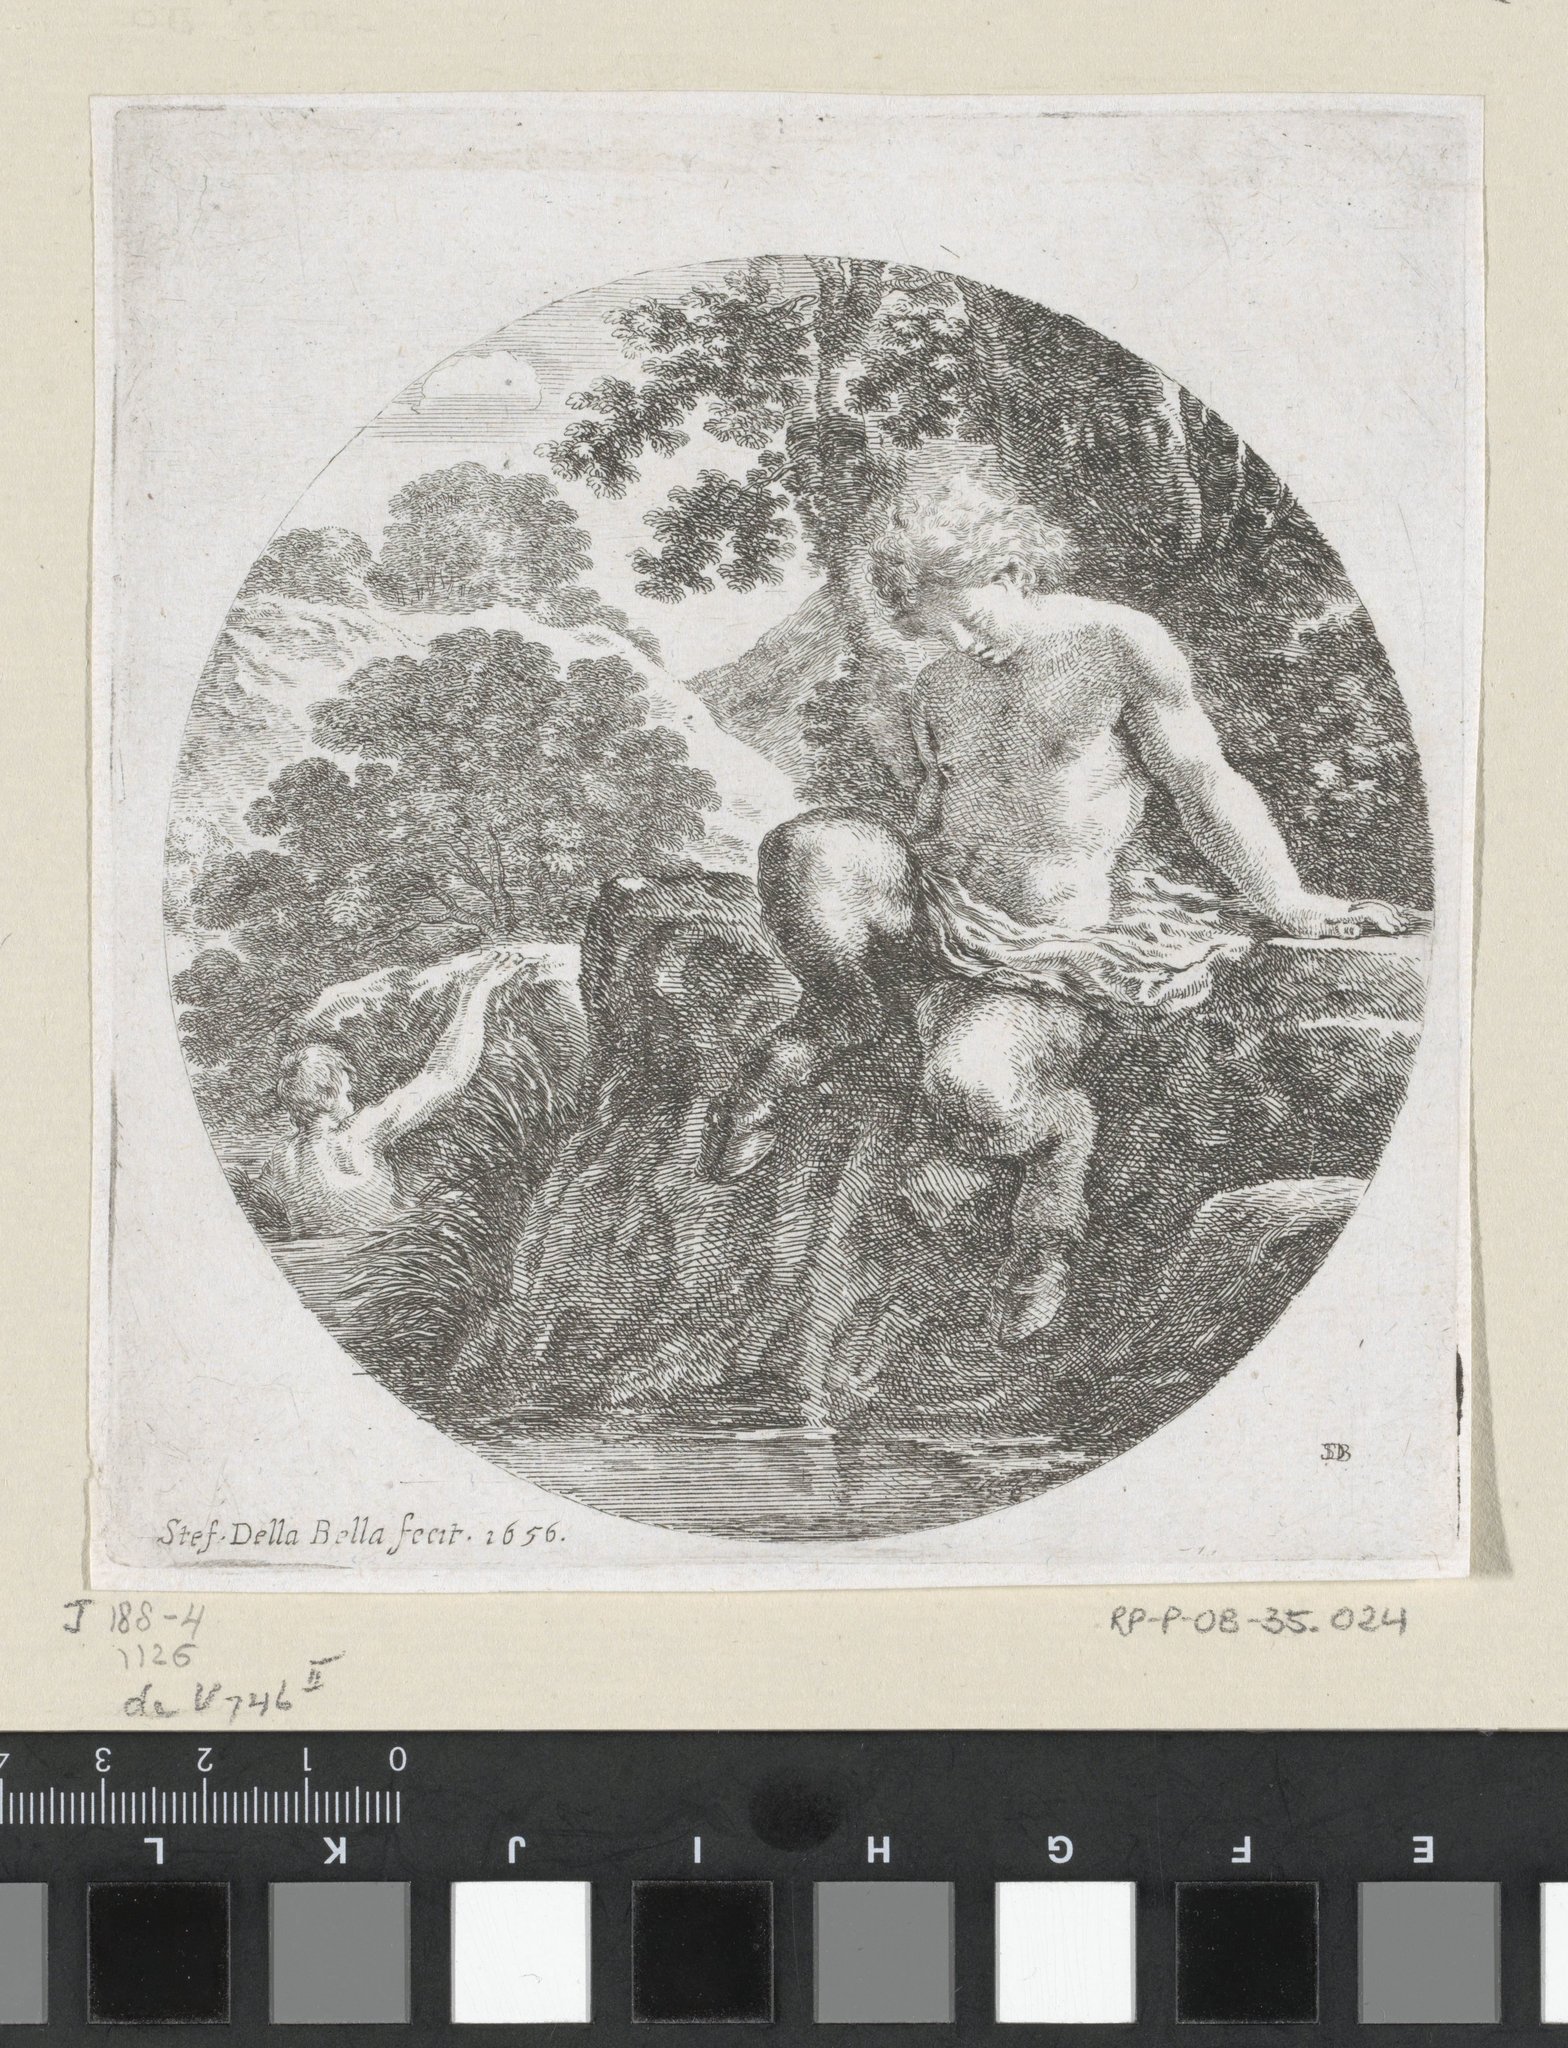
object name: print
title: Landschappen en havens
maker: stefano della bella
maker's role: draughtsman, print maker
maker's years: 1610-1664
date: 1656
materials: paper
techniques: etching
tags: satyr(s) (in general), taking a bath - aa - in the open air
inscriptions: collector's mark: Lugt 240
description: Een jonge sater zit op de oever van een beekje in een landschap. Verderop zit een tweede sater in het water.